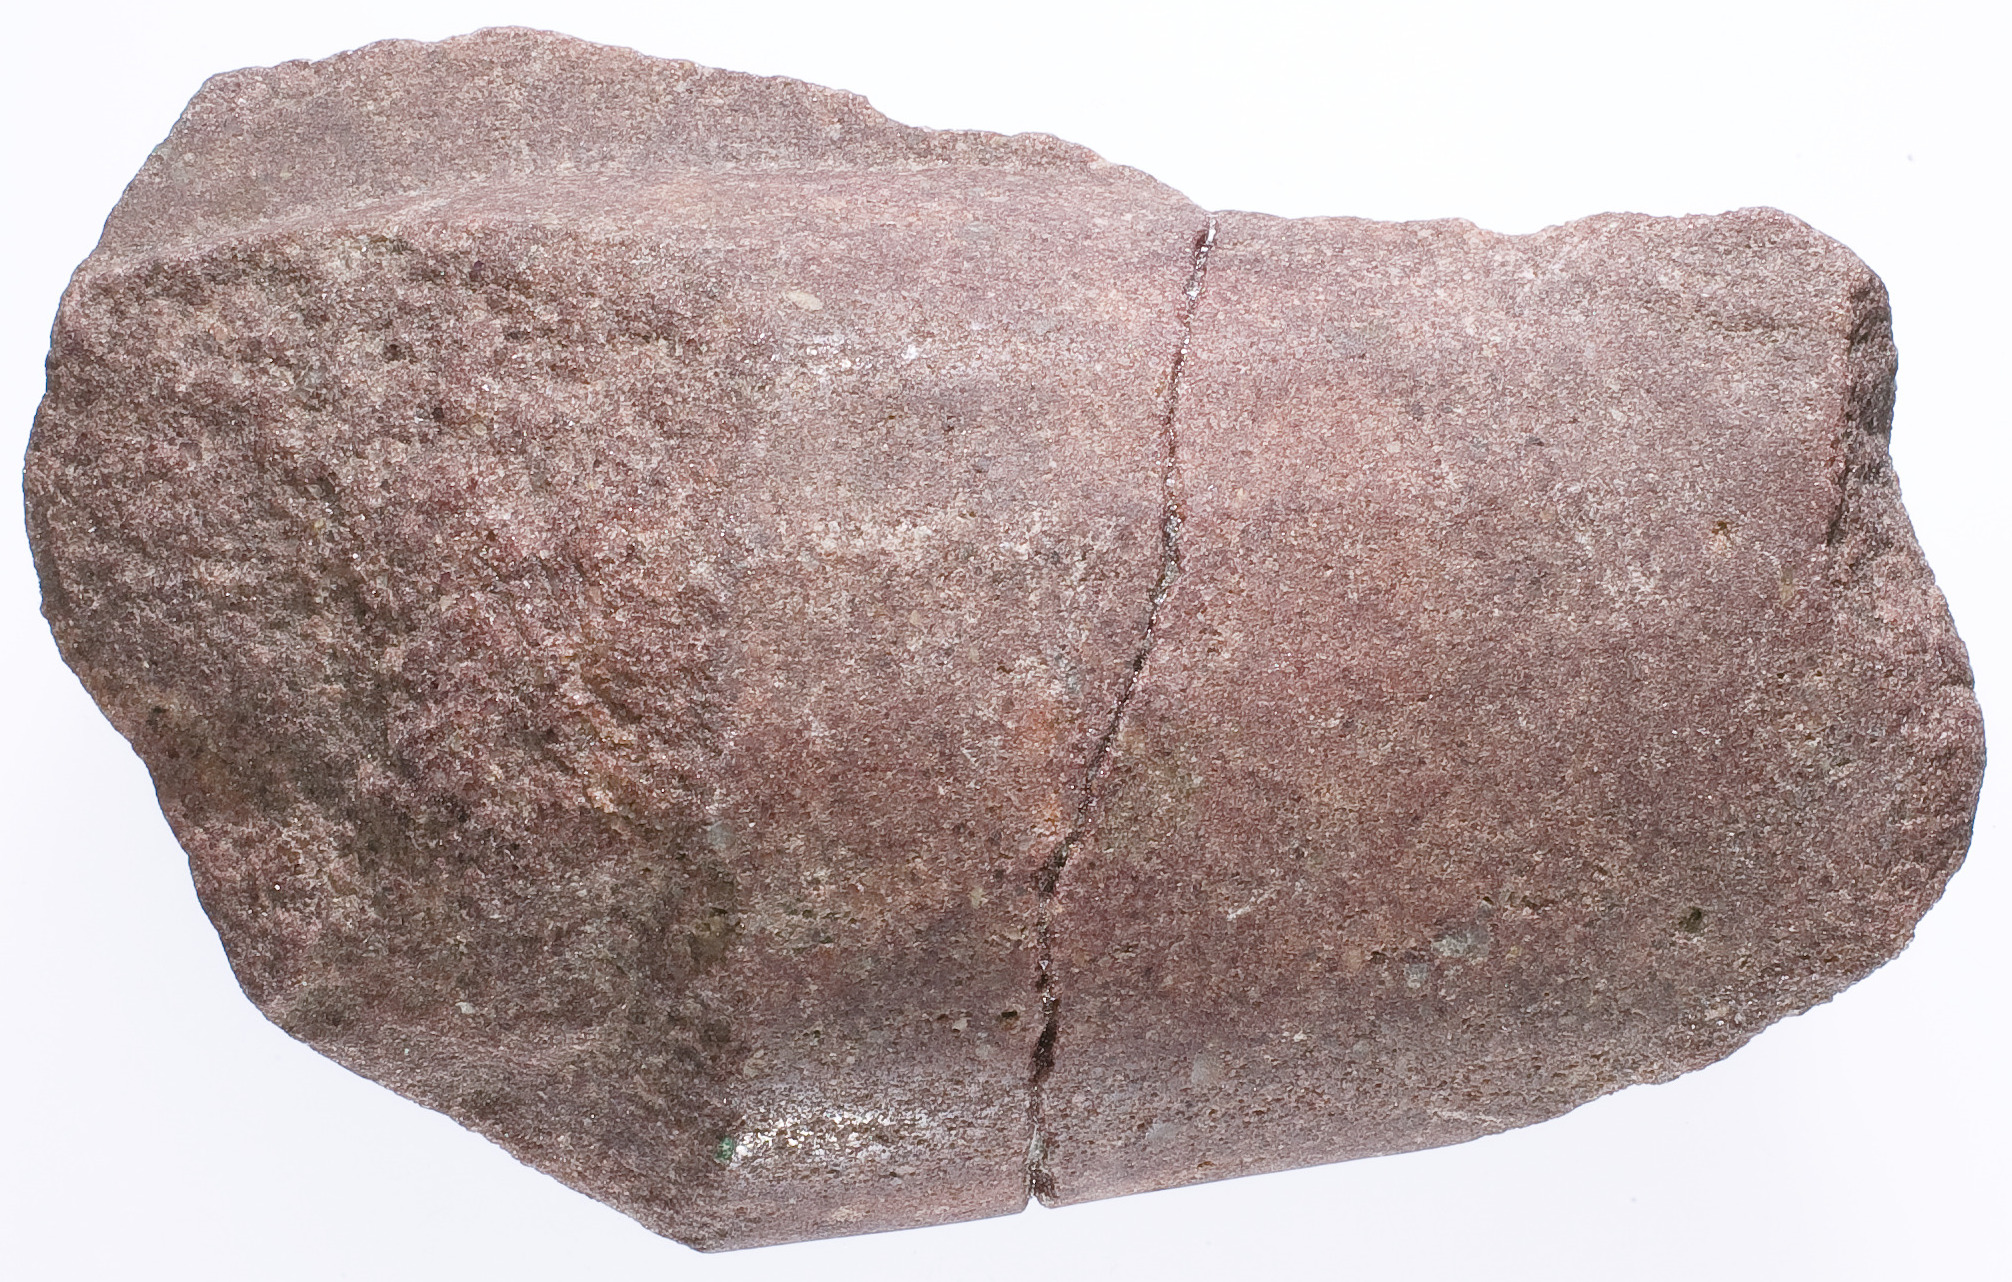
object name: right forearm, bent, garment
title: Bent right forearm with garment pleats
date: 1353-1336 BCE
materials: quartzite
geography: egypt